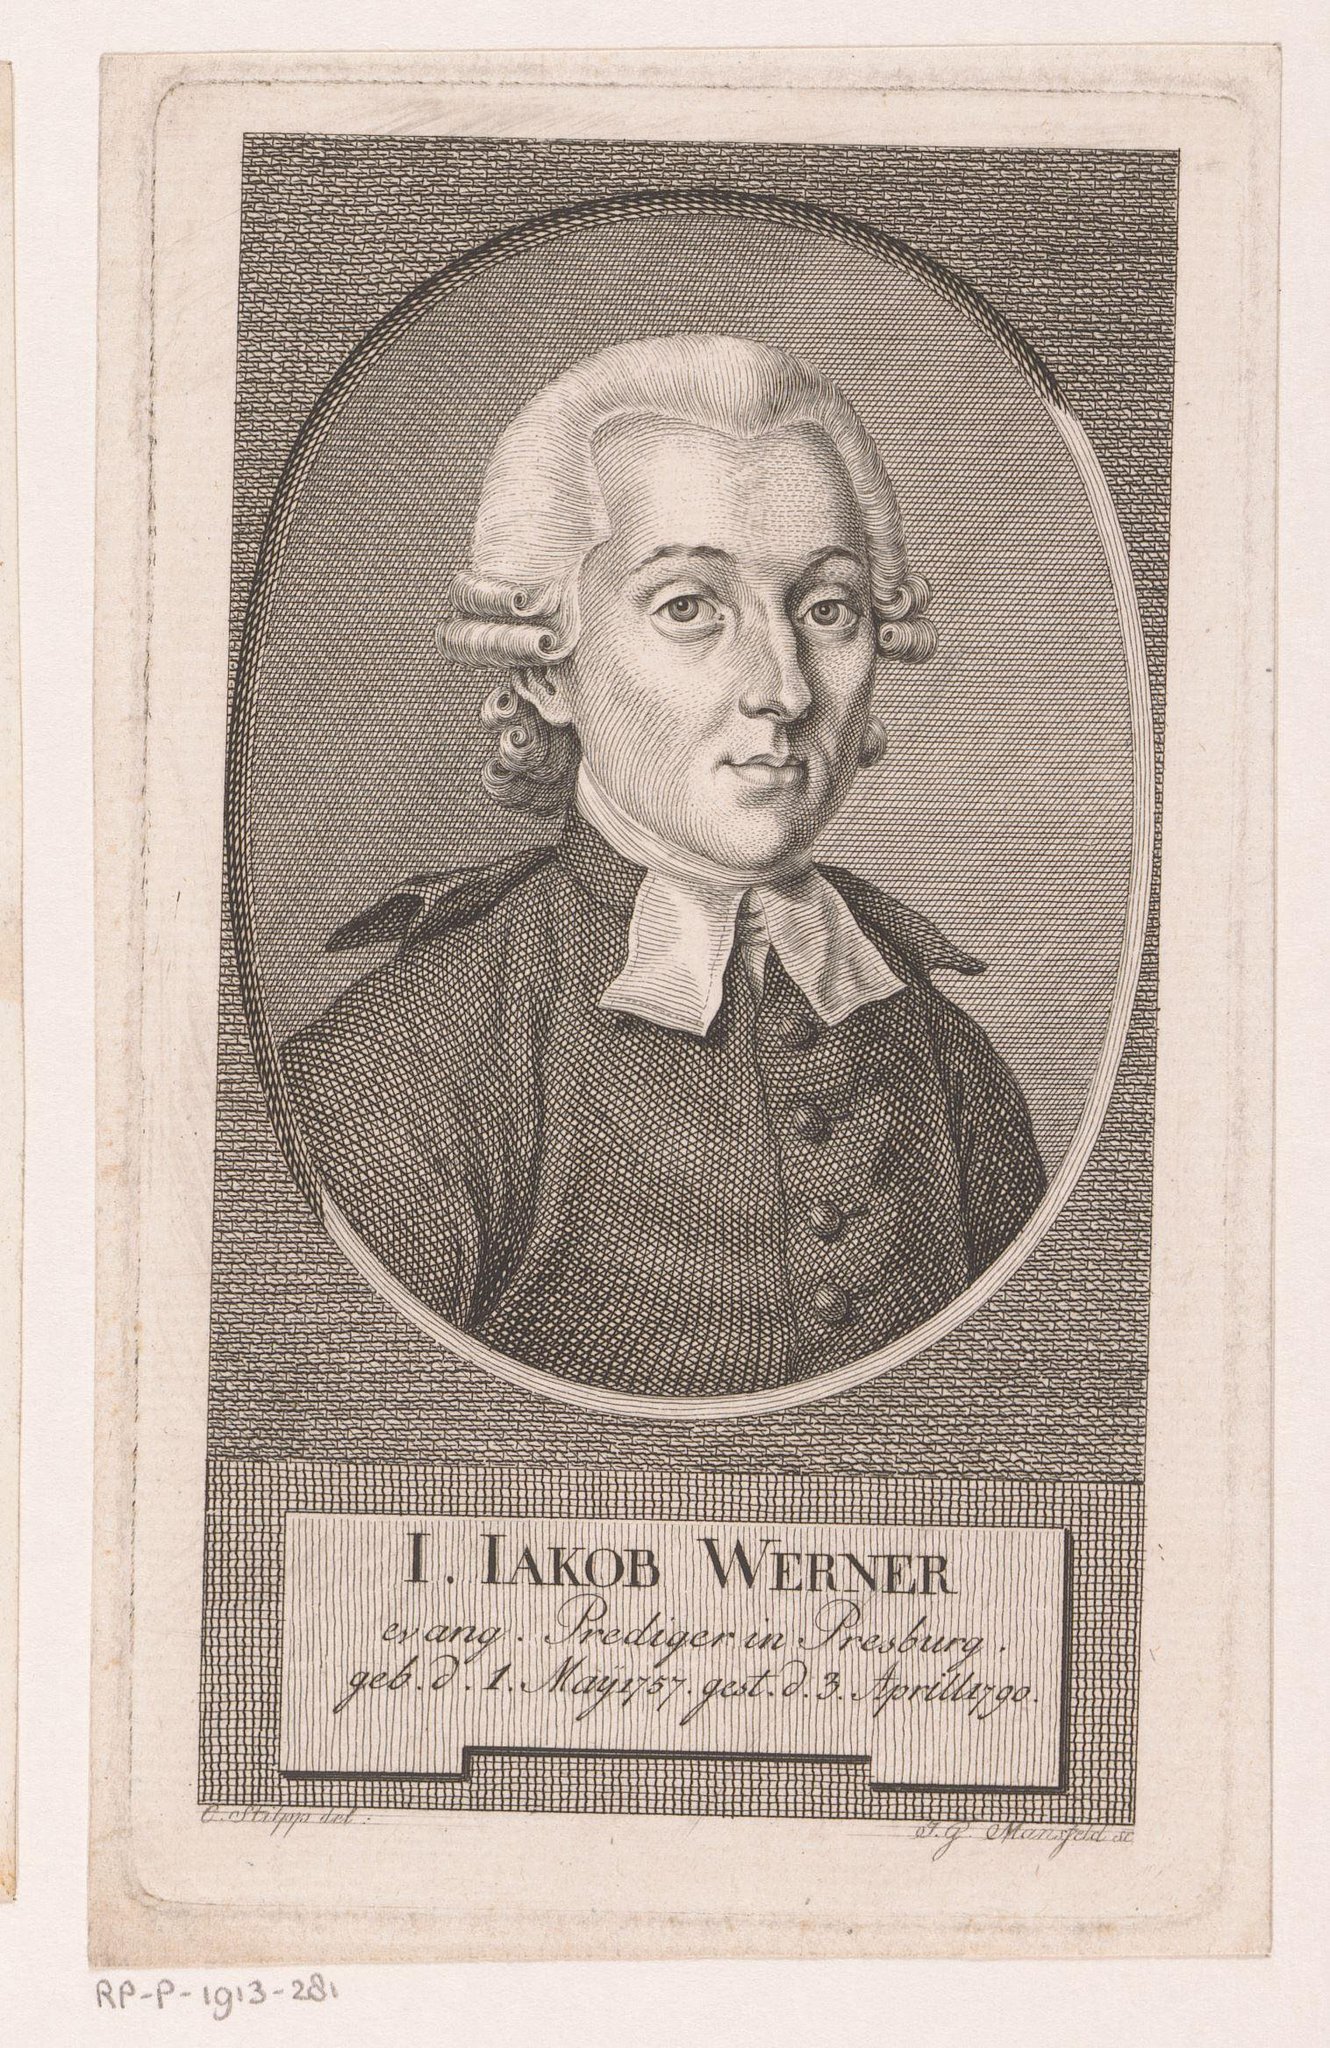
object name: print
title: Portret van Johann Jakob Werner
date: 1774-1817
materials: paper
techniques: engraving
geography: vienna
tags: historical persons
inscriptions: collector's mark: Lugt 2228